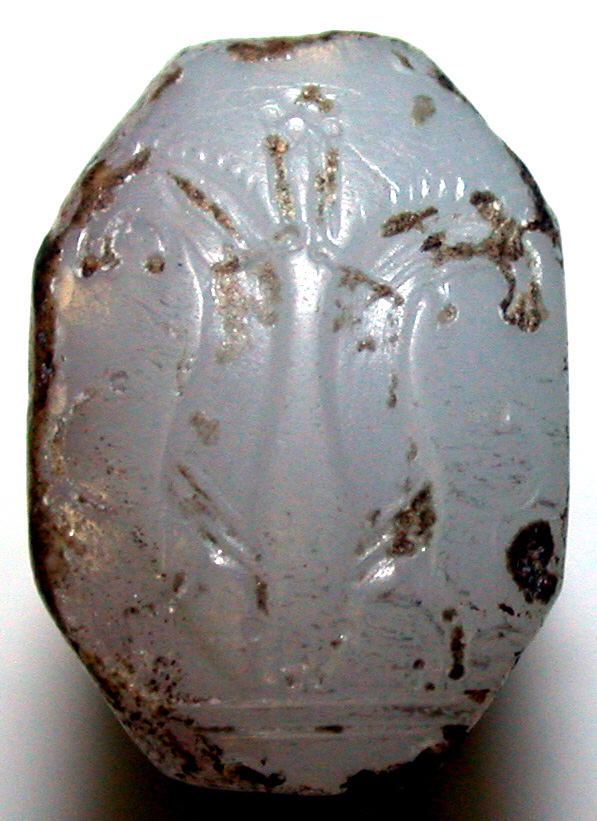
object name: stamp seal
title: Stamp seal (octagonal pyramid) with animal contest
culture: achaemenid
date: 600-301 BCE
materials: stone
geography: mesopotamia